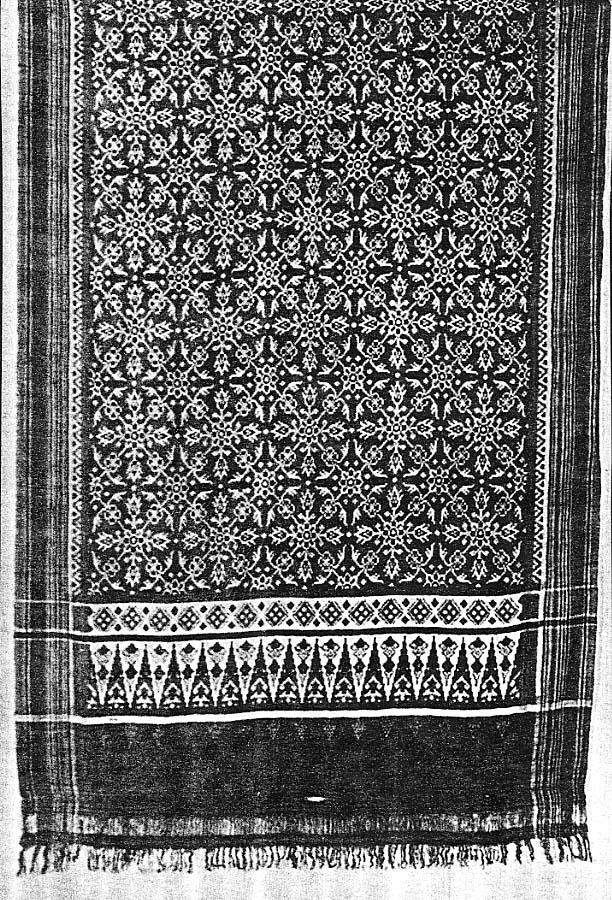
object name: patolu sari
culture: indian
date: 1801-1900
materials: metal, silk, thread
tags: flowers